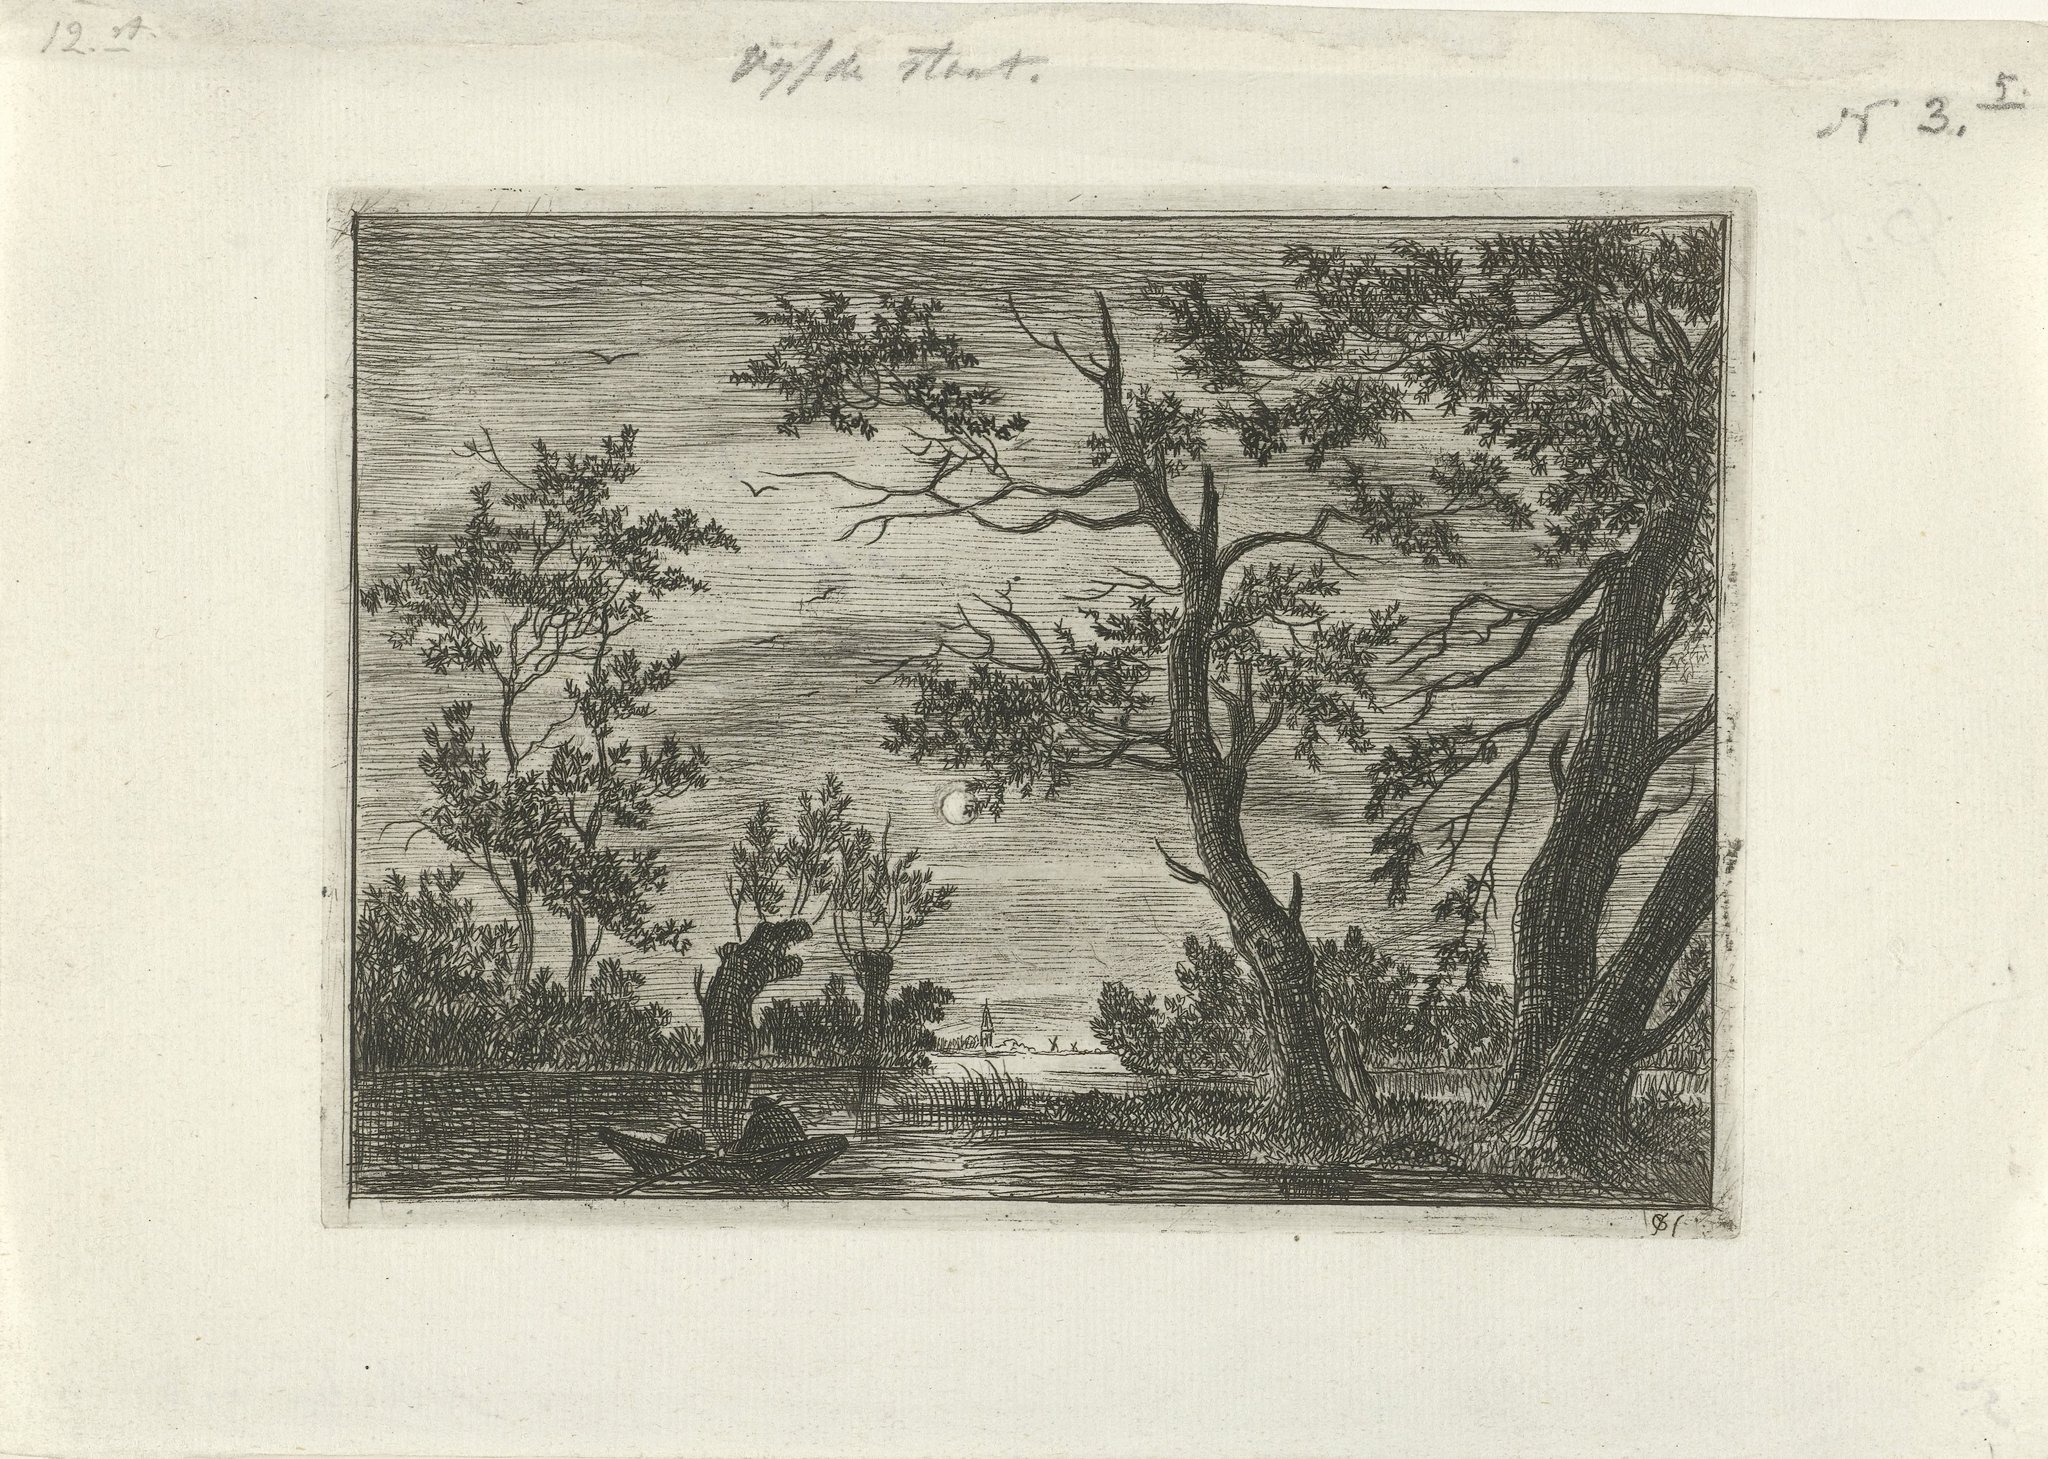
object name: print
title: Nachtgezicht met een figuur in een boot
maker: cornelis van der griendt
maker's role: draughtsman, painter, print maker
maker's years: 1827-1918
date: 1850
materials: paper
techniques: drypoint, etching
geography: netherlands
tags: rowing-boat, canoe, etc., windmill, landscapes with waters, waterscapes, seascapes (in the temperate zone) - hh - ideal landscapes (+ landscape with figures, staffage)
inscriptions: collector's mark: Lugt 2228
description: Nachtgezicht met een figuur in een roeiboot omgeven door water en bomen. Op de achtergrond een kerktoren en twee molens.